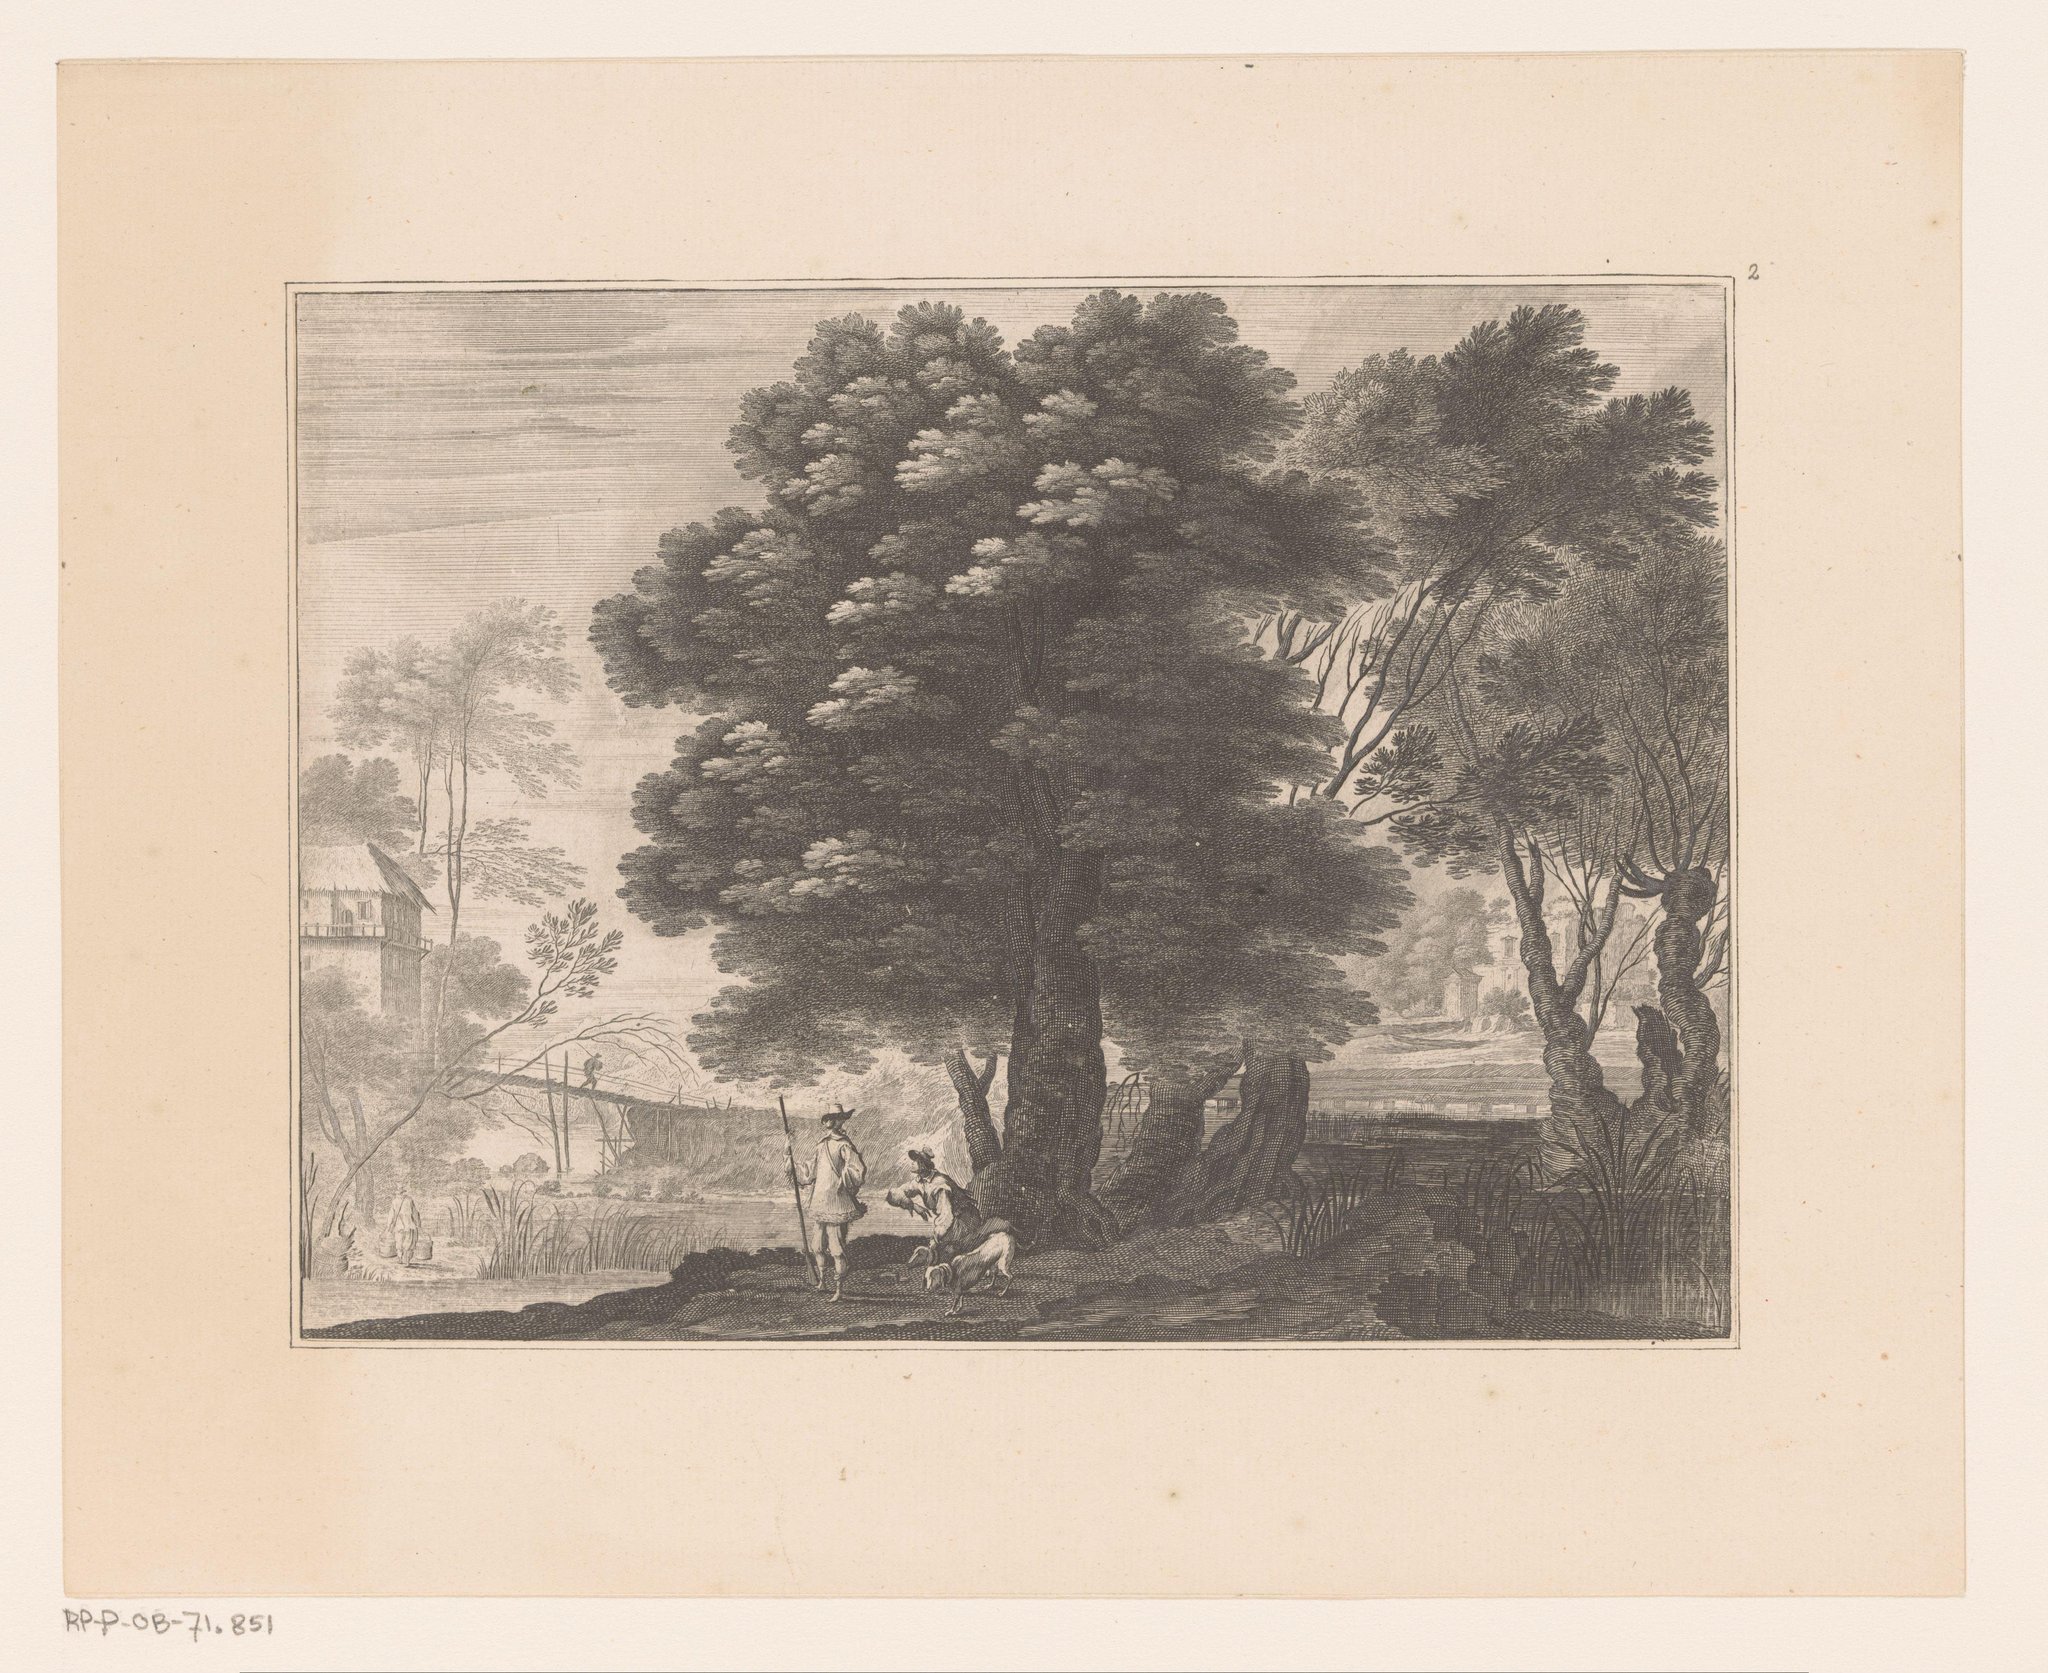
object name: print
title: Landschap met twee mannen en honden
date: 1613-1695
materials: paper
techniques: engraving, etching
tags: landscapes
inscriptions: collector's mark: Lugt 240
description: Prenten met het signatuur 'Perelle' kunnen zowel door vader Gabriel als door zonen Nicolas en Adam gemaakt zijn.